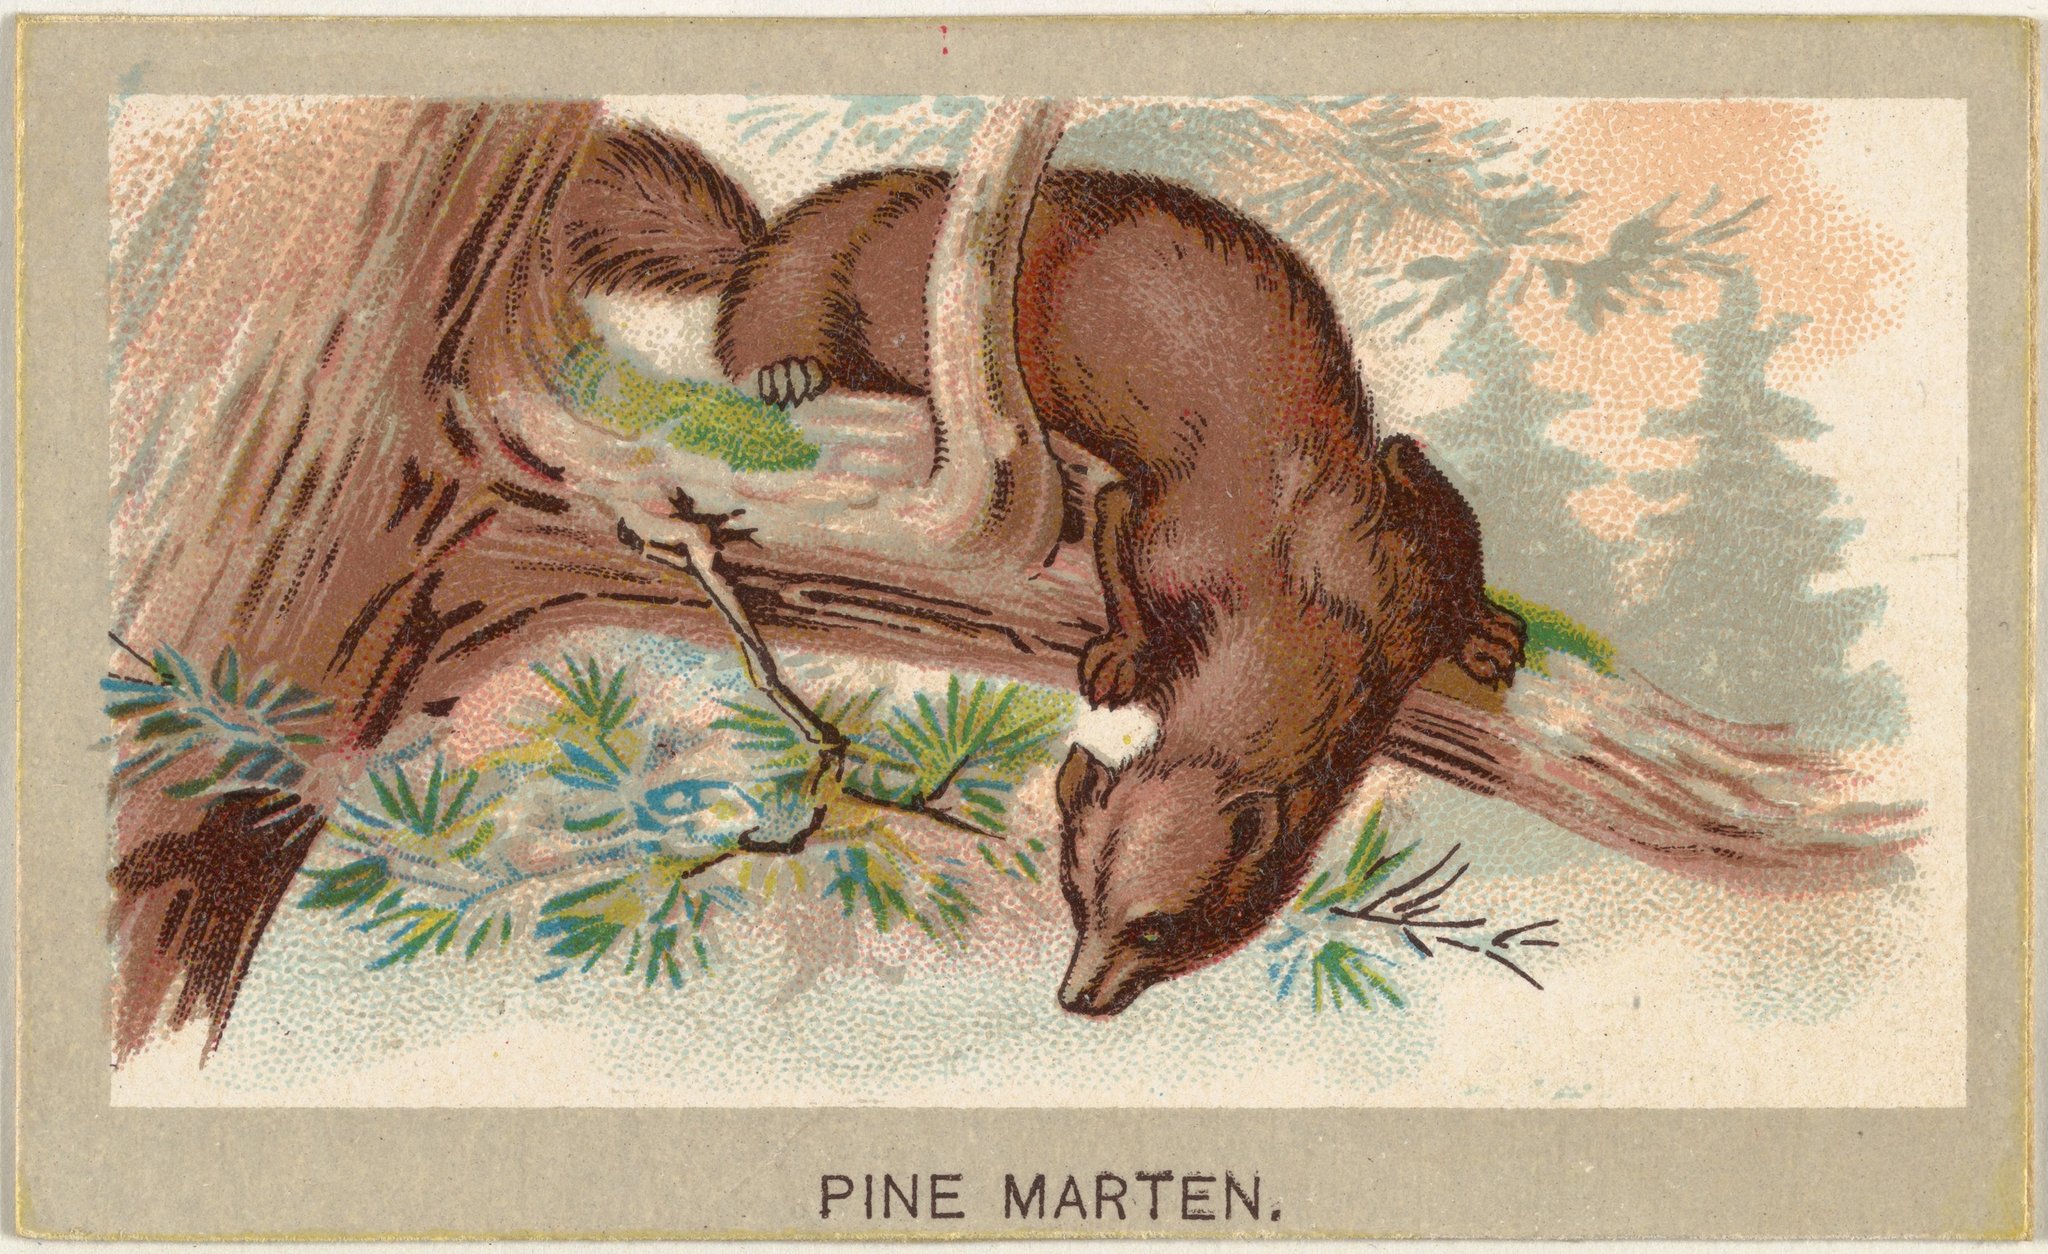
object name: print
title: Pine Marten, from the Animals of the World series (T180), issued by Abdul Cigarettes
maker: abdul cigarettes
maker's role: publisher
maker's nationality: american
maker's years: 1881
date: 1881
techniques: color lithograph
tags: animals